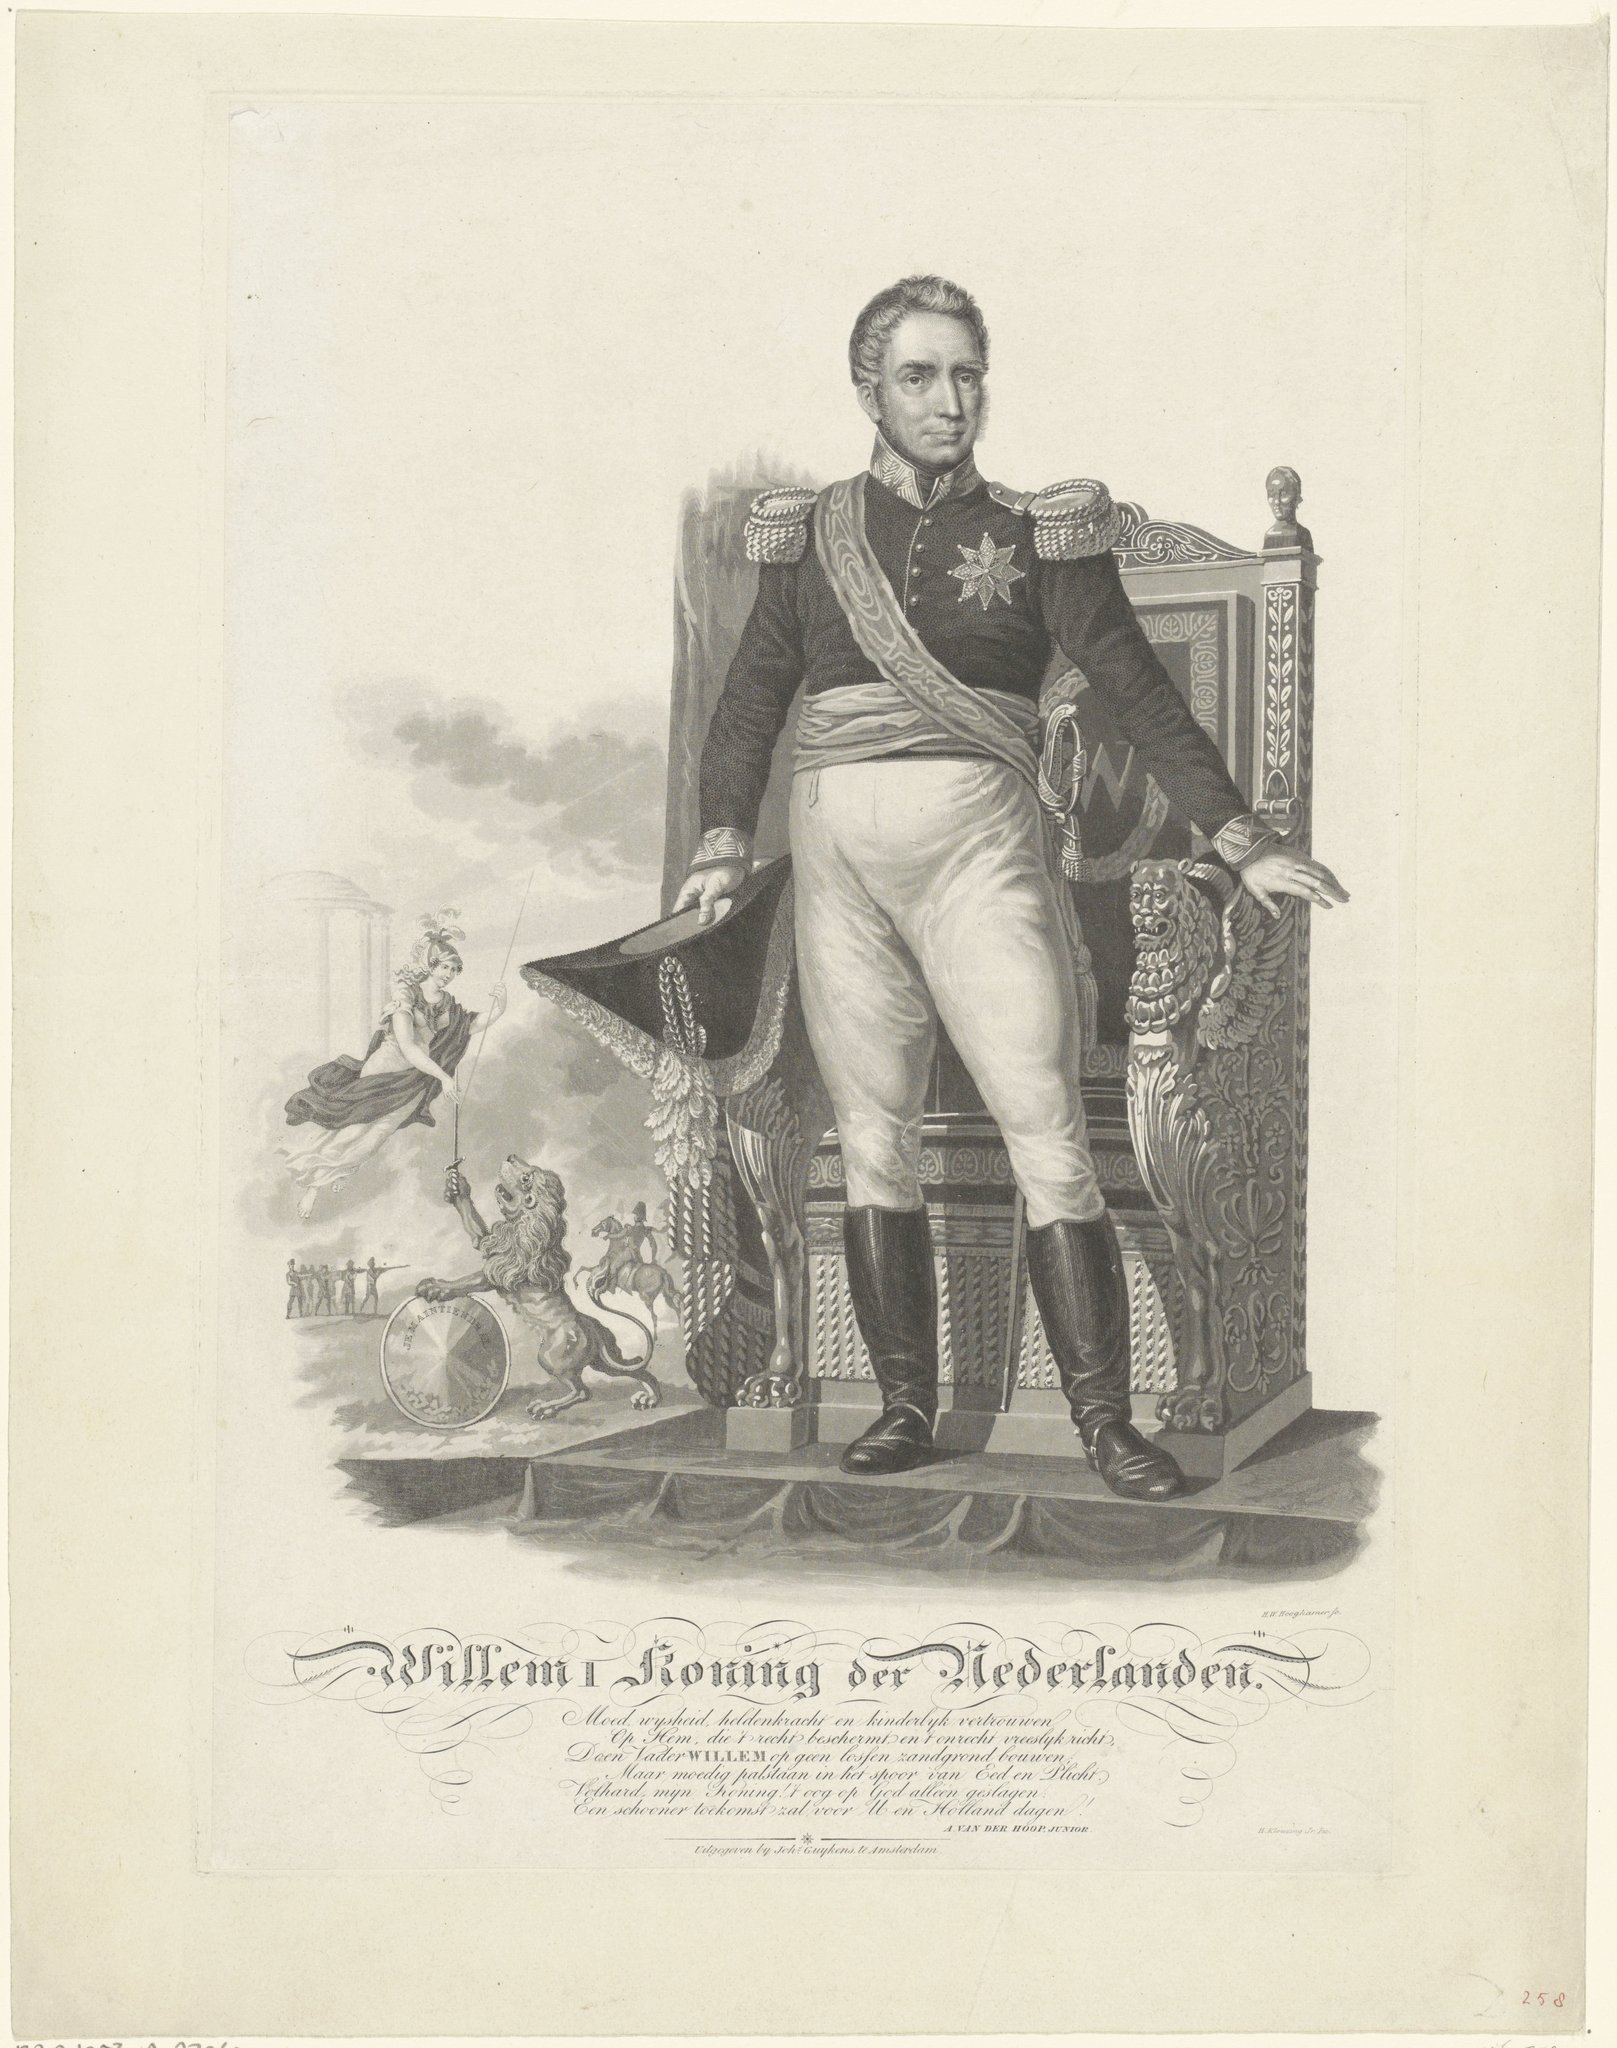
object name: print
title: Portret van Willem I Frederik, koning der Nederlanden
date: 1815-1864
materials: paper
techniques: aquatint, etching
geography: netherlands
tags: the hague, berlin, william i of the netherlands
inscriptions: collector's mark: Lugt 2228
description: Portret van Willem I Frederik. Hij staat voor een troon met in zijn rechterhand zijn hoed. Op de achtergrond Oorlog die een zwaard aan de Nederlandse Leeuw geeft en een veldslag. In de ondermarge zijn naam, zijn titel en zes regels Nederlandse tekst.